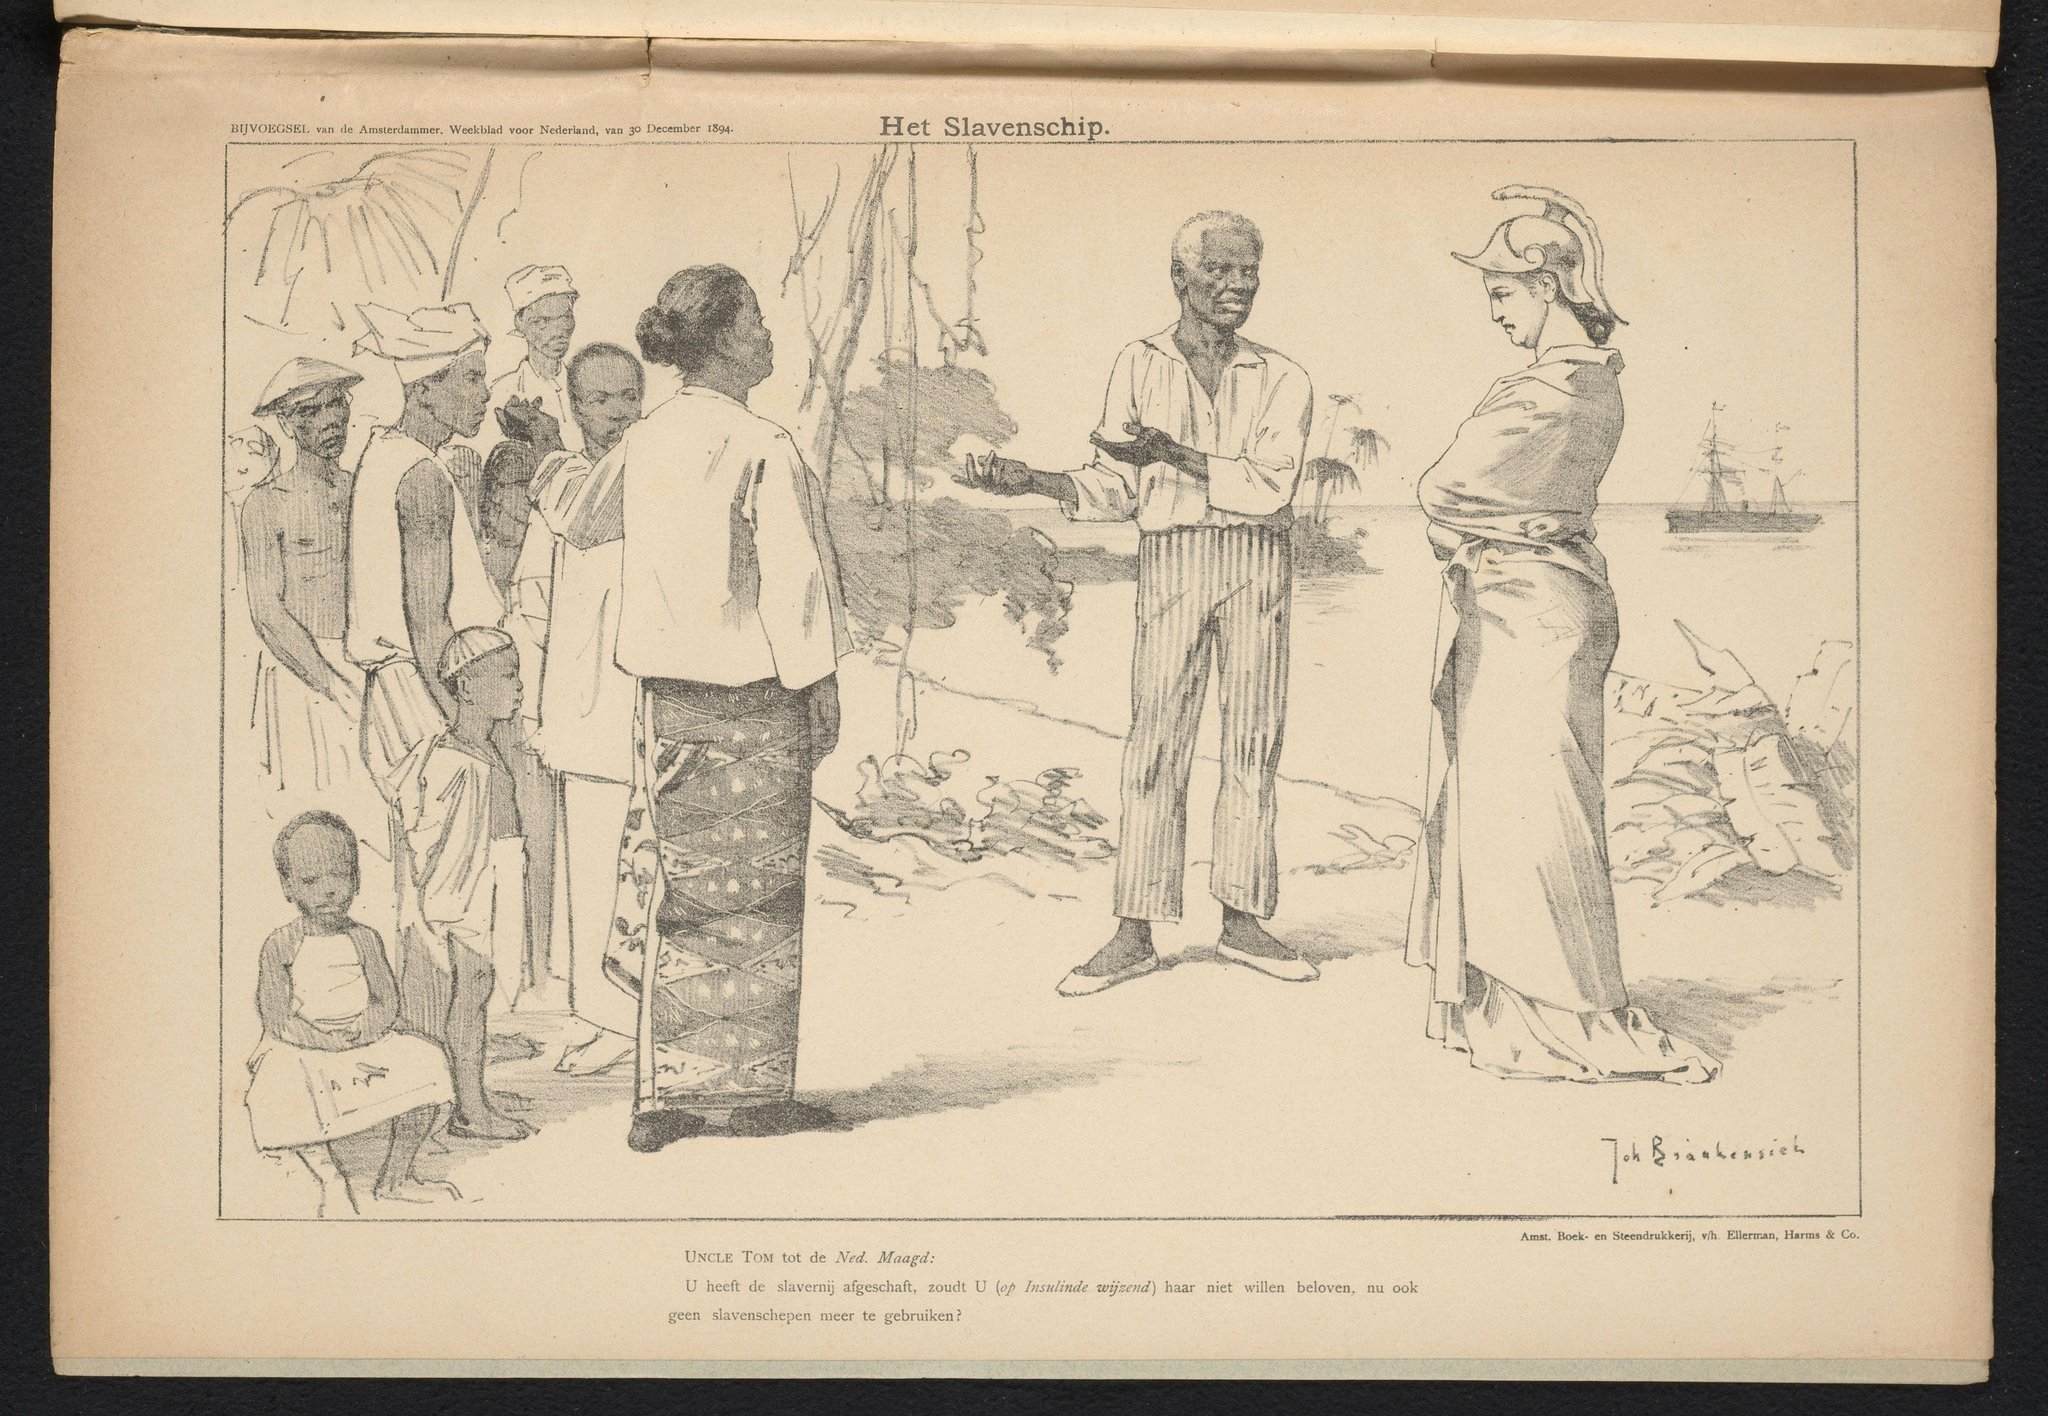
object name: cartoon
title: Het Slavenschip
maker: johan braakensiek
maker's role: draughtsman, print maker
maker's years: 1858-1940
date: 1894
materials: paper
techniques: lithograph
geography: netherlands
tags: personifications of countries, nations, states, districts, etc., slavery; serfs and enslaved persons, americans with african roots, african-americans, political caricatures and satires, dutch east indies, the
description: Een zwarte man, in het onderschrift aangeduid als 'Uncle Tom', vraagt de Nederlandse Maagd, om na de afschaffing van de slavernij ook in Nederlands-Indië geen slavenschepen meer te gebruiken. Links staat Insulinde met een groep Indonesische personen.